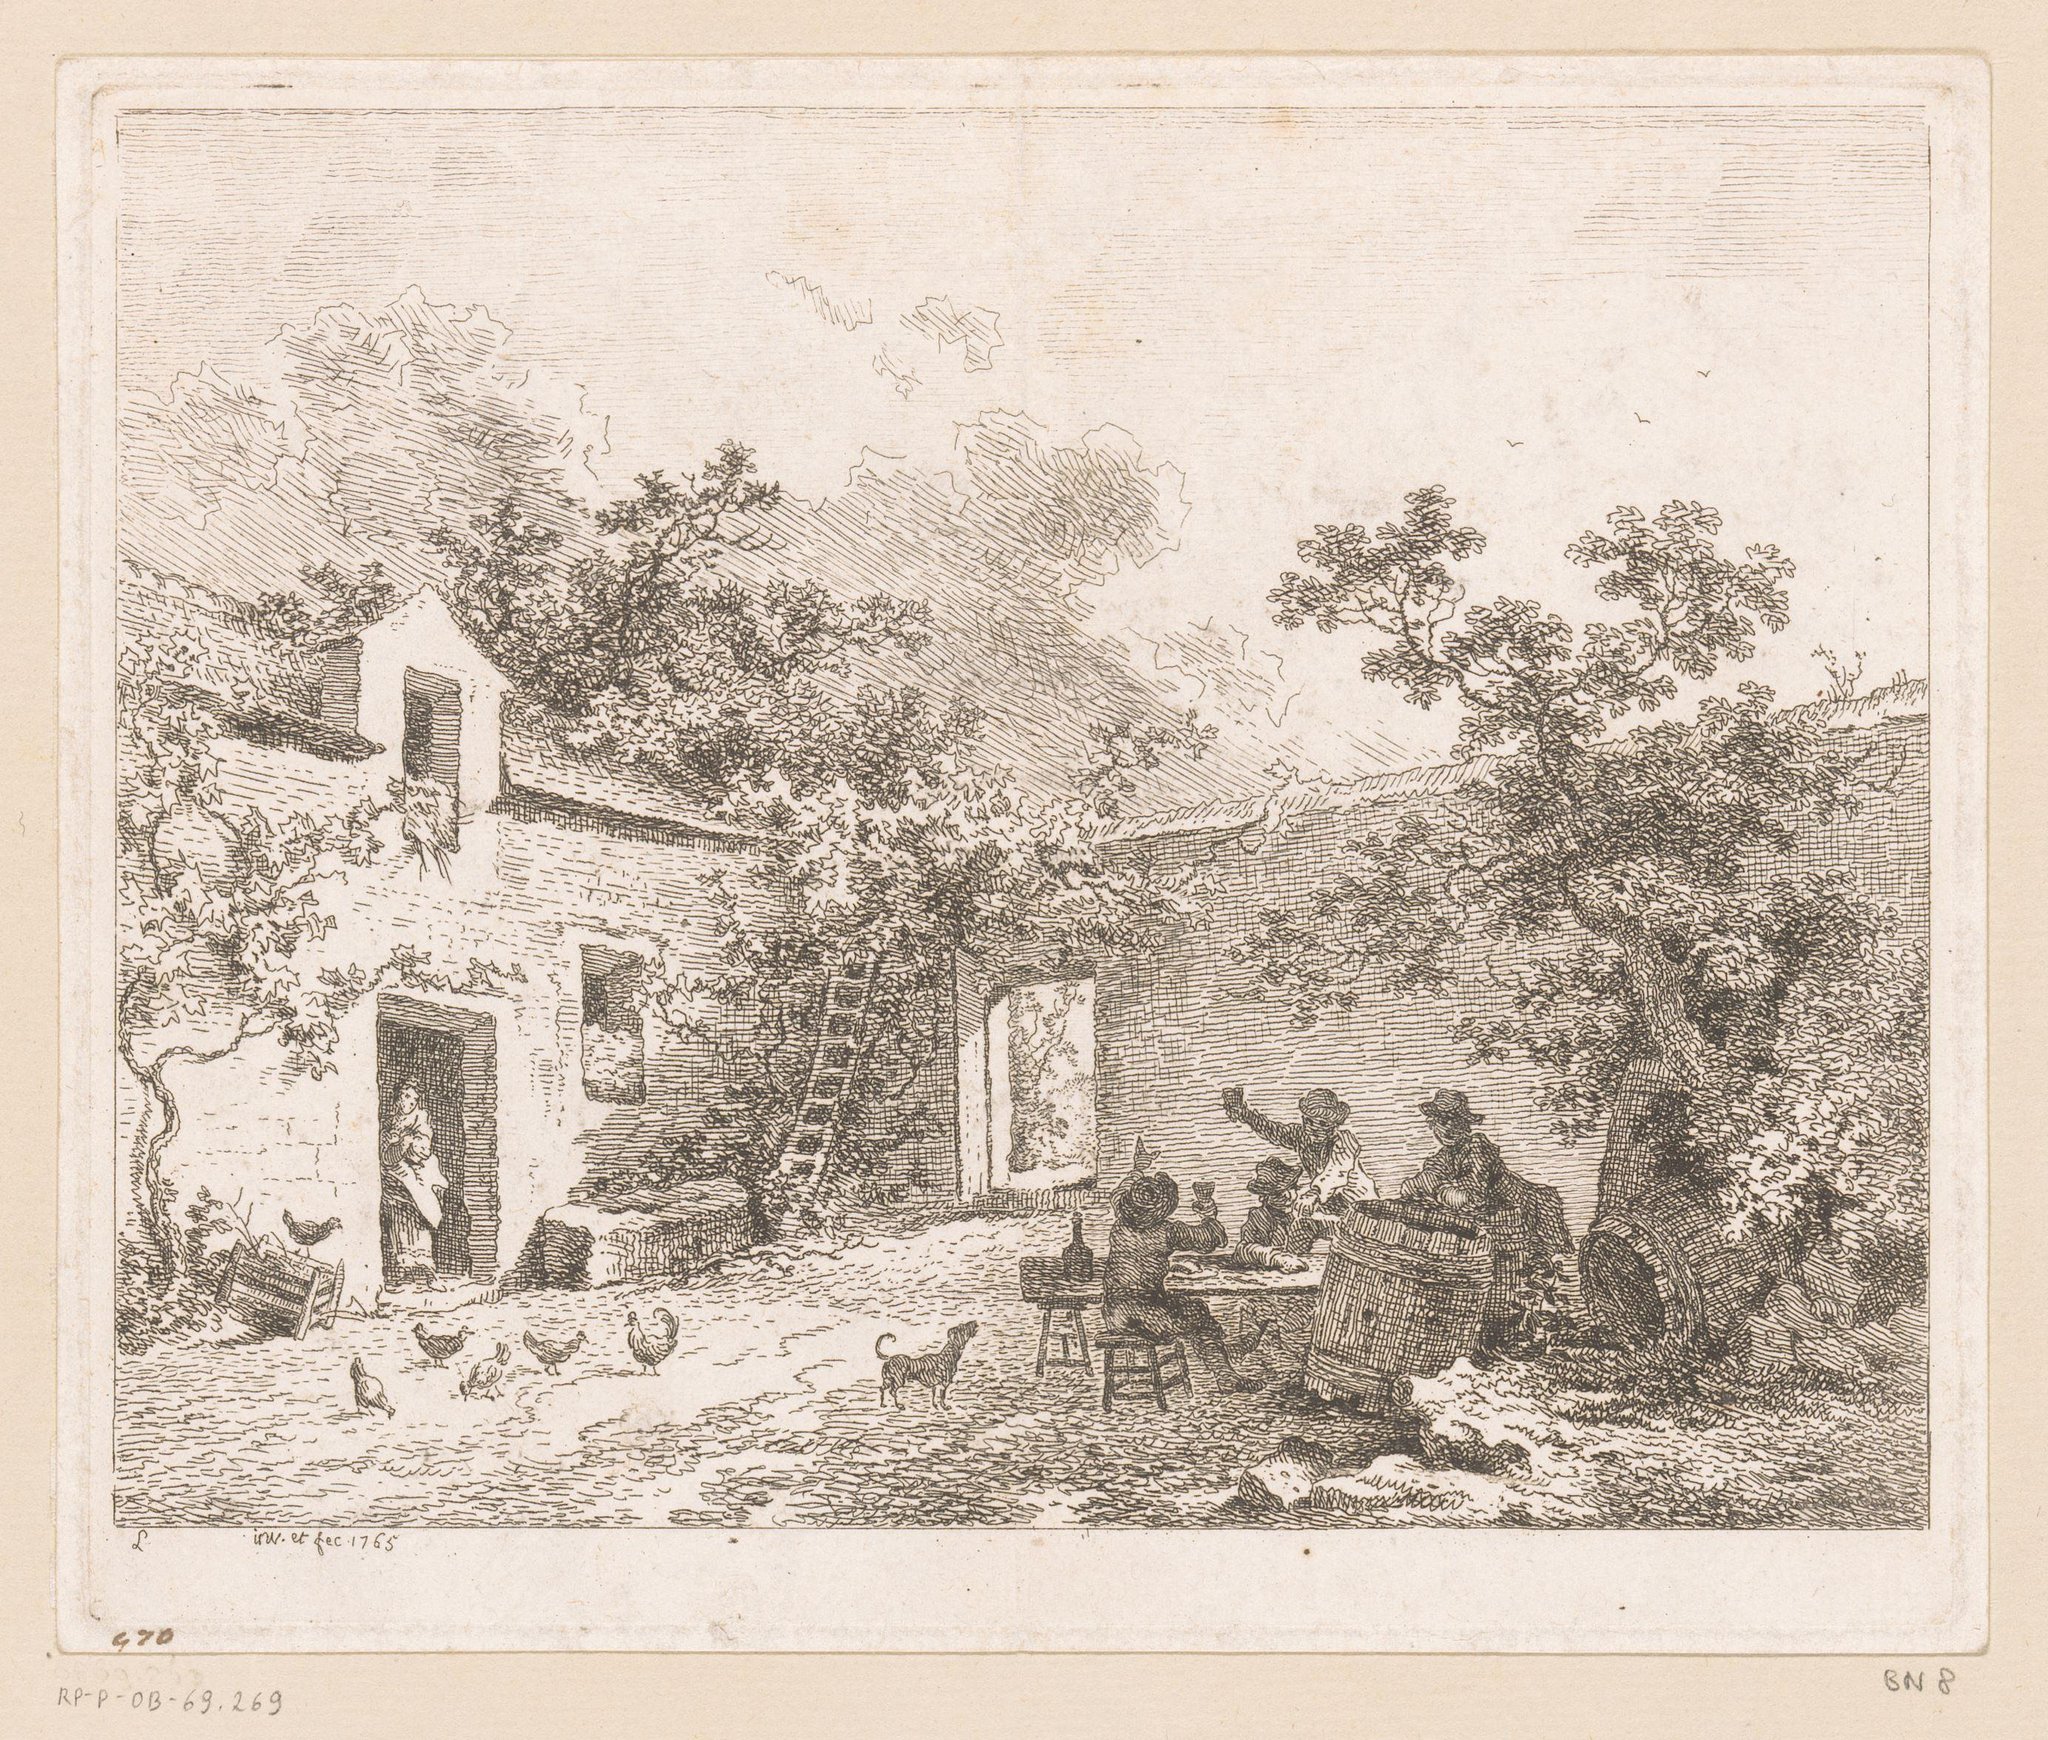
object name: print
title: Binnenplaats met drinkende mannen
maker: jean baptiste denis lempereur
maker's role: print maker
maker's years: 1740-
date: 1765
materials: paper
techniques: etching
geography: france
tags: open door, courtyard, drinking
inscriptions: collector's mark: Lugt 240